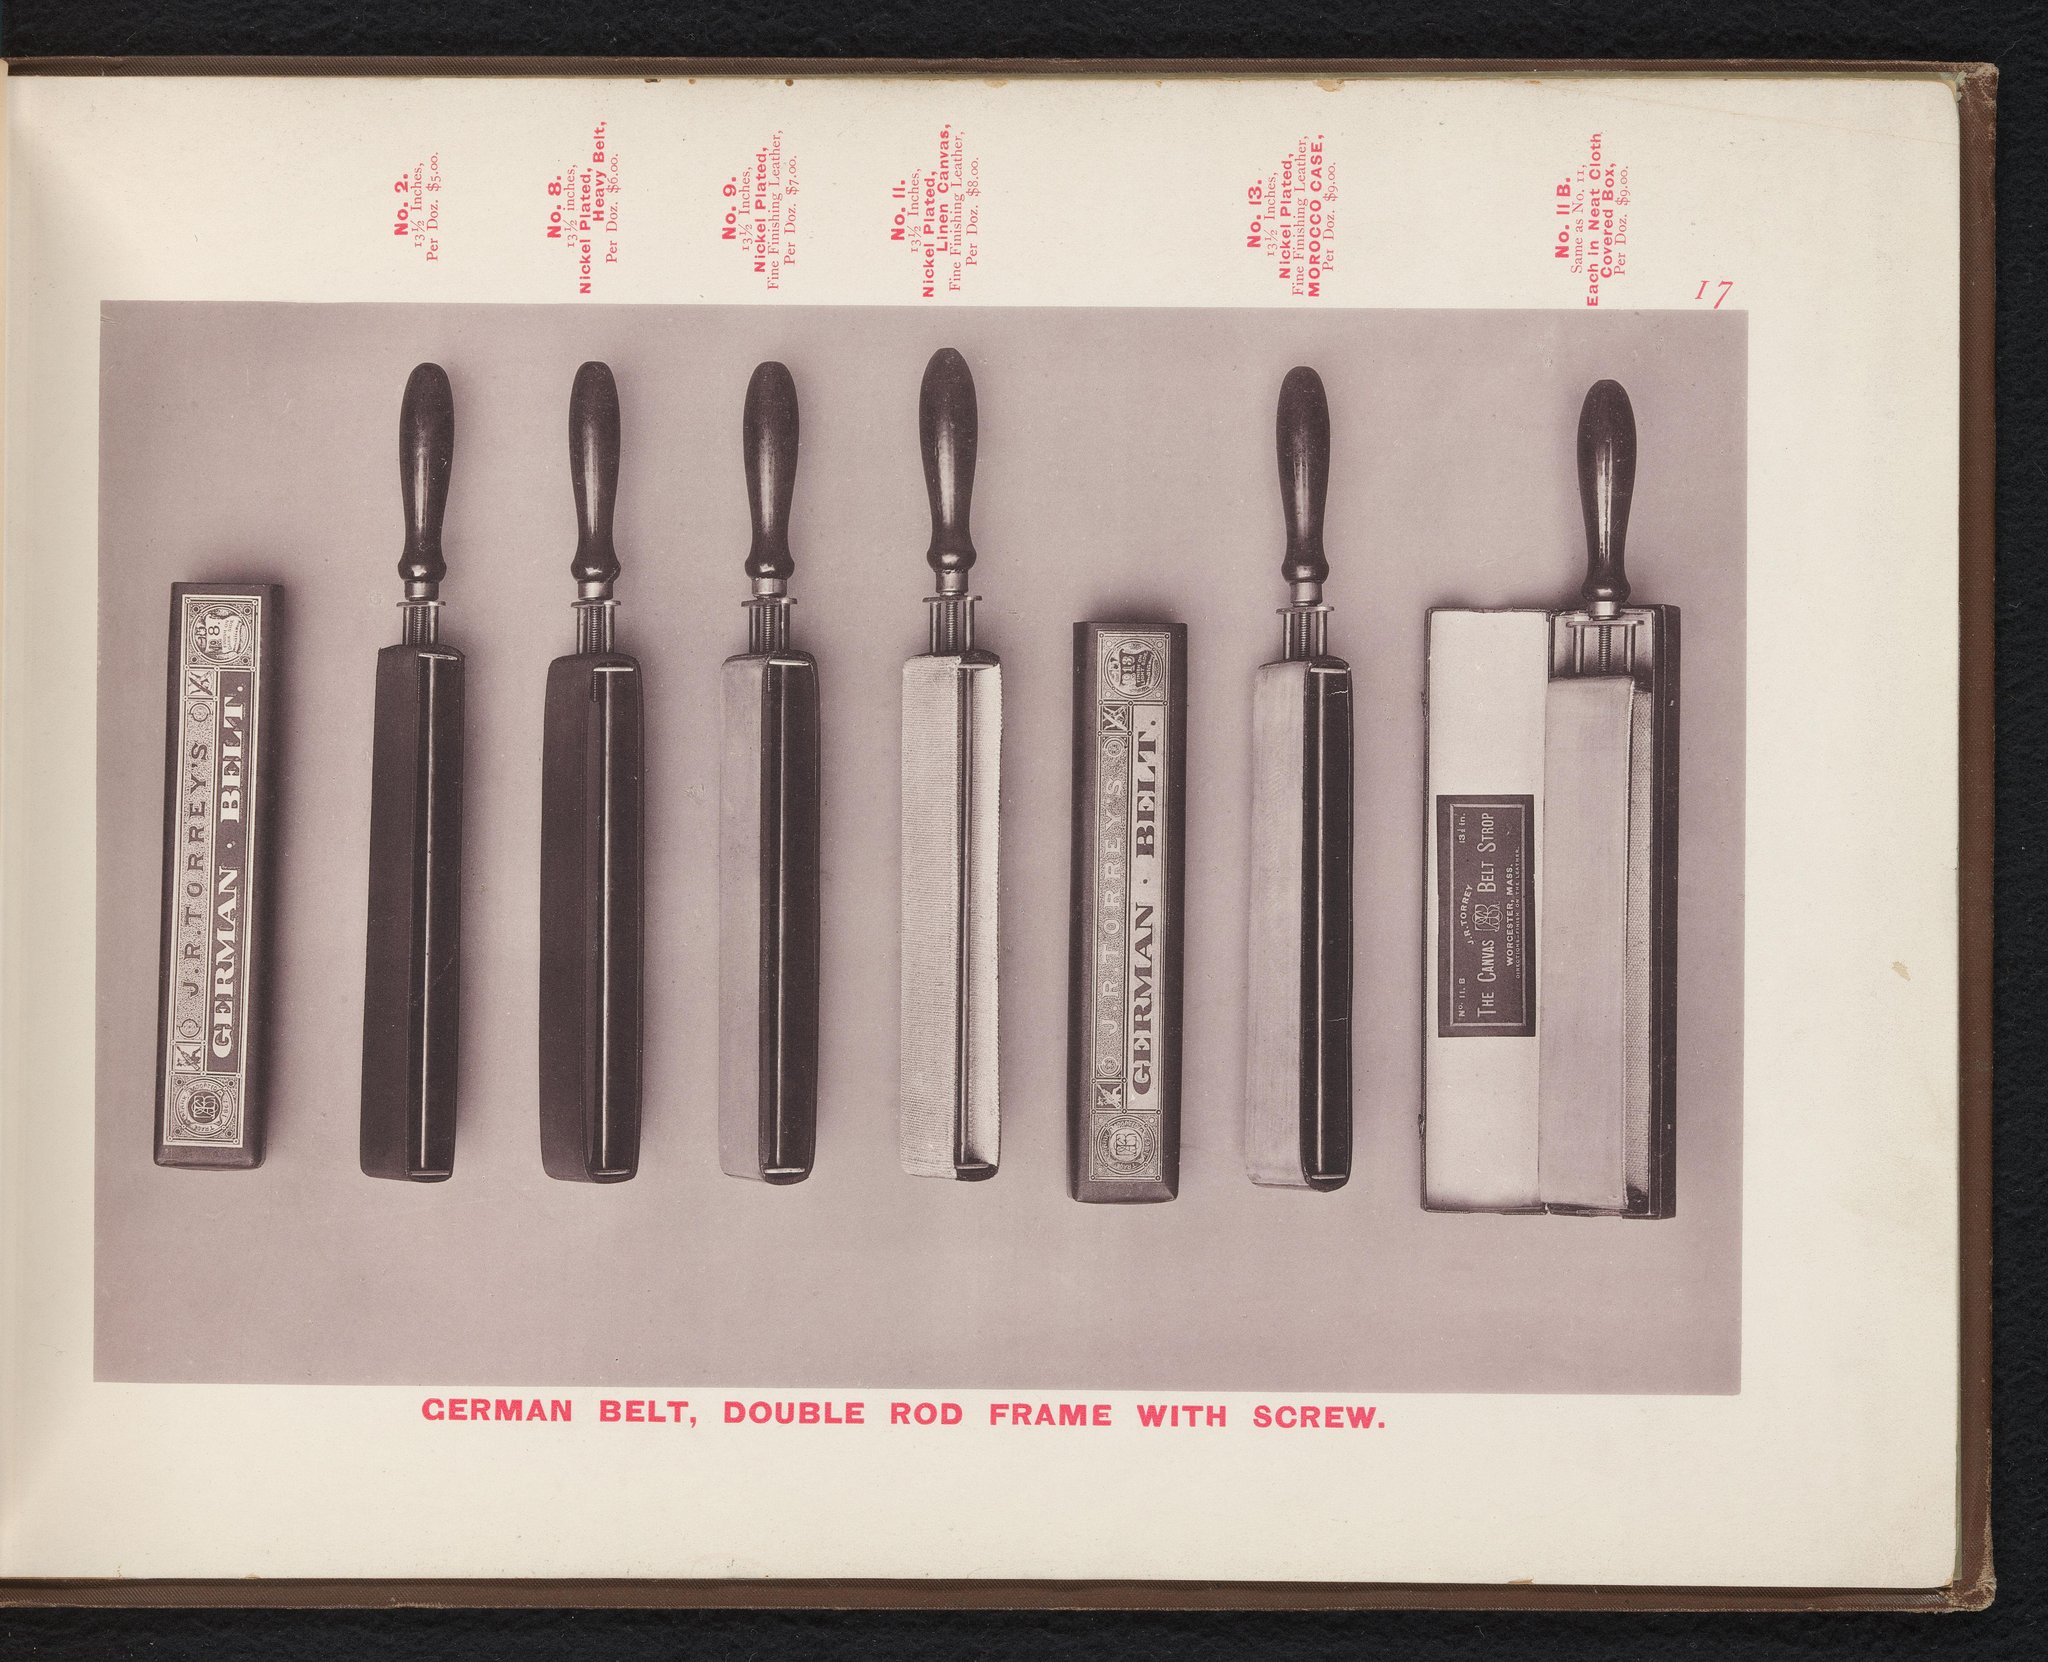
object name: page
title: Zes scheerriemen van J.R. Torrey Razor Co. in Duitse stijl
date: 1876-1881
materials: paper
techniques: photograph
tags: care of the body, hygiene, razor